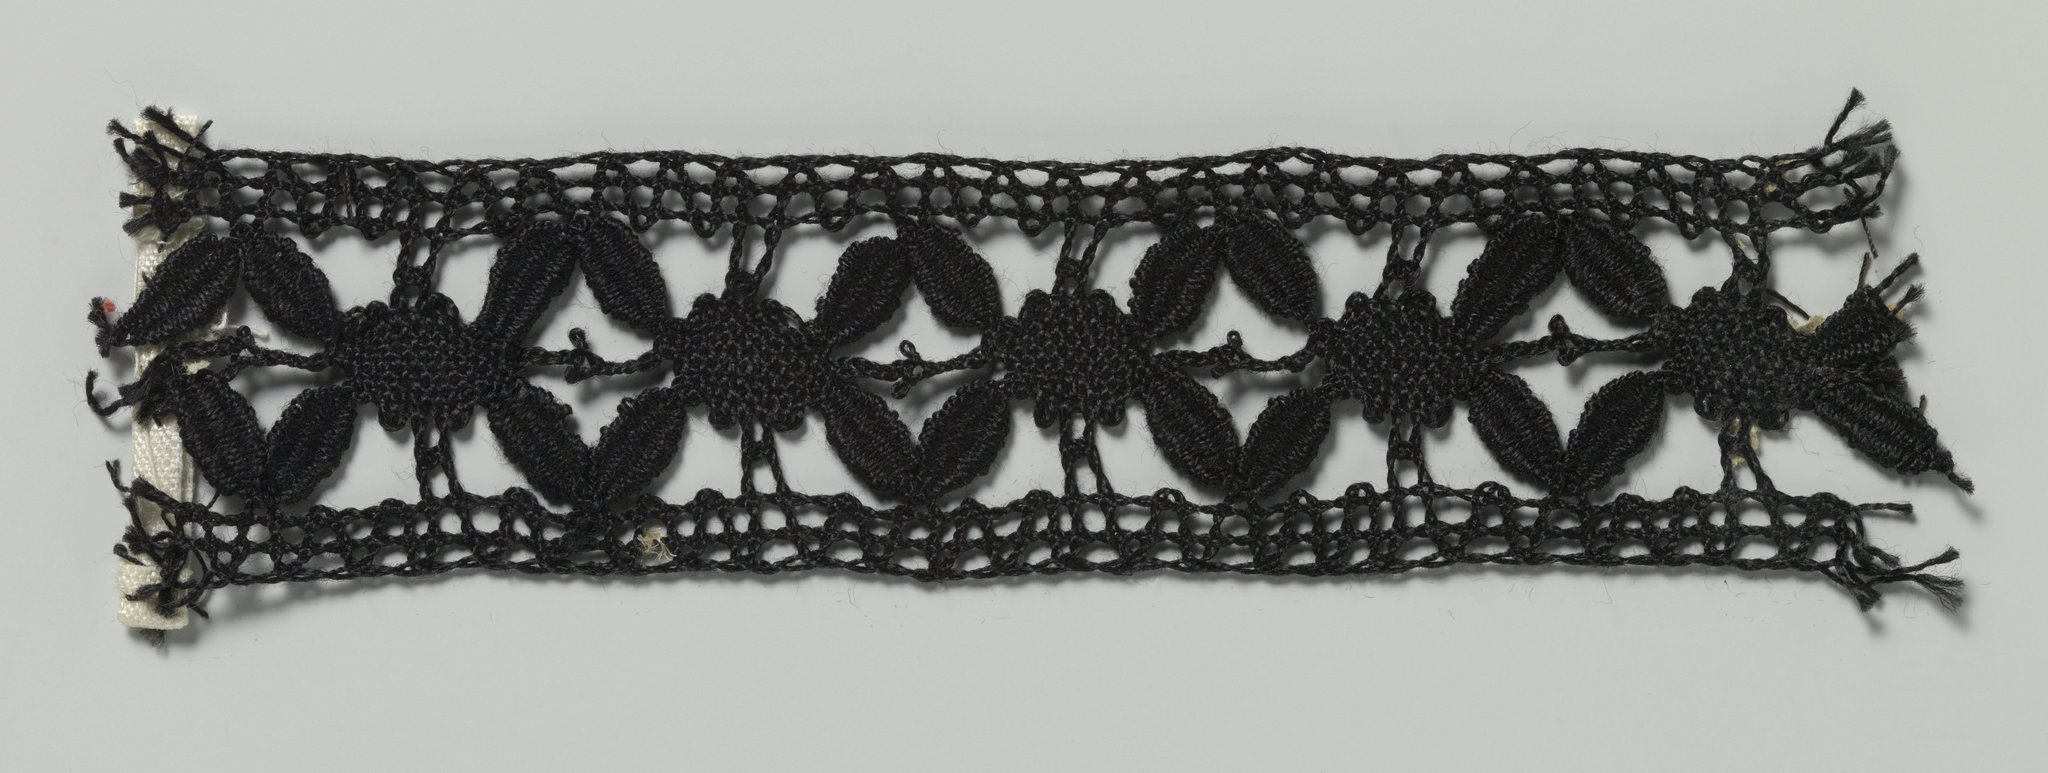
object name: strip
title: Strook kloskant met vier blaadjes rond bloemhart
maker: Anonymous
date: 1875-1899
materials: silk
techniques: lace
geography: russia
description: Strook of tussenzetsel van zwarte kloskant, Cluny-kant. Het zich herhalende patroon bestaat op de middenlijn uit een bloemhart waaraan naar vier kanten toe bloemblaadjes bevestigd zijn. De opeenvolgende bloemharten zijn met een horizontale gepicoteerde vlecht aan elkaar verbonden en met dubbele overstekende paren aan boven- en onderzijde van de strook. De bloemharten zijn gemaakt in linnenslag. De bloemblaadjes zijn gemaakt in vormslag. Boven- en onderzijde van de strook zijn recht afgewerkt met een open zigzag-randje.